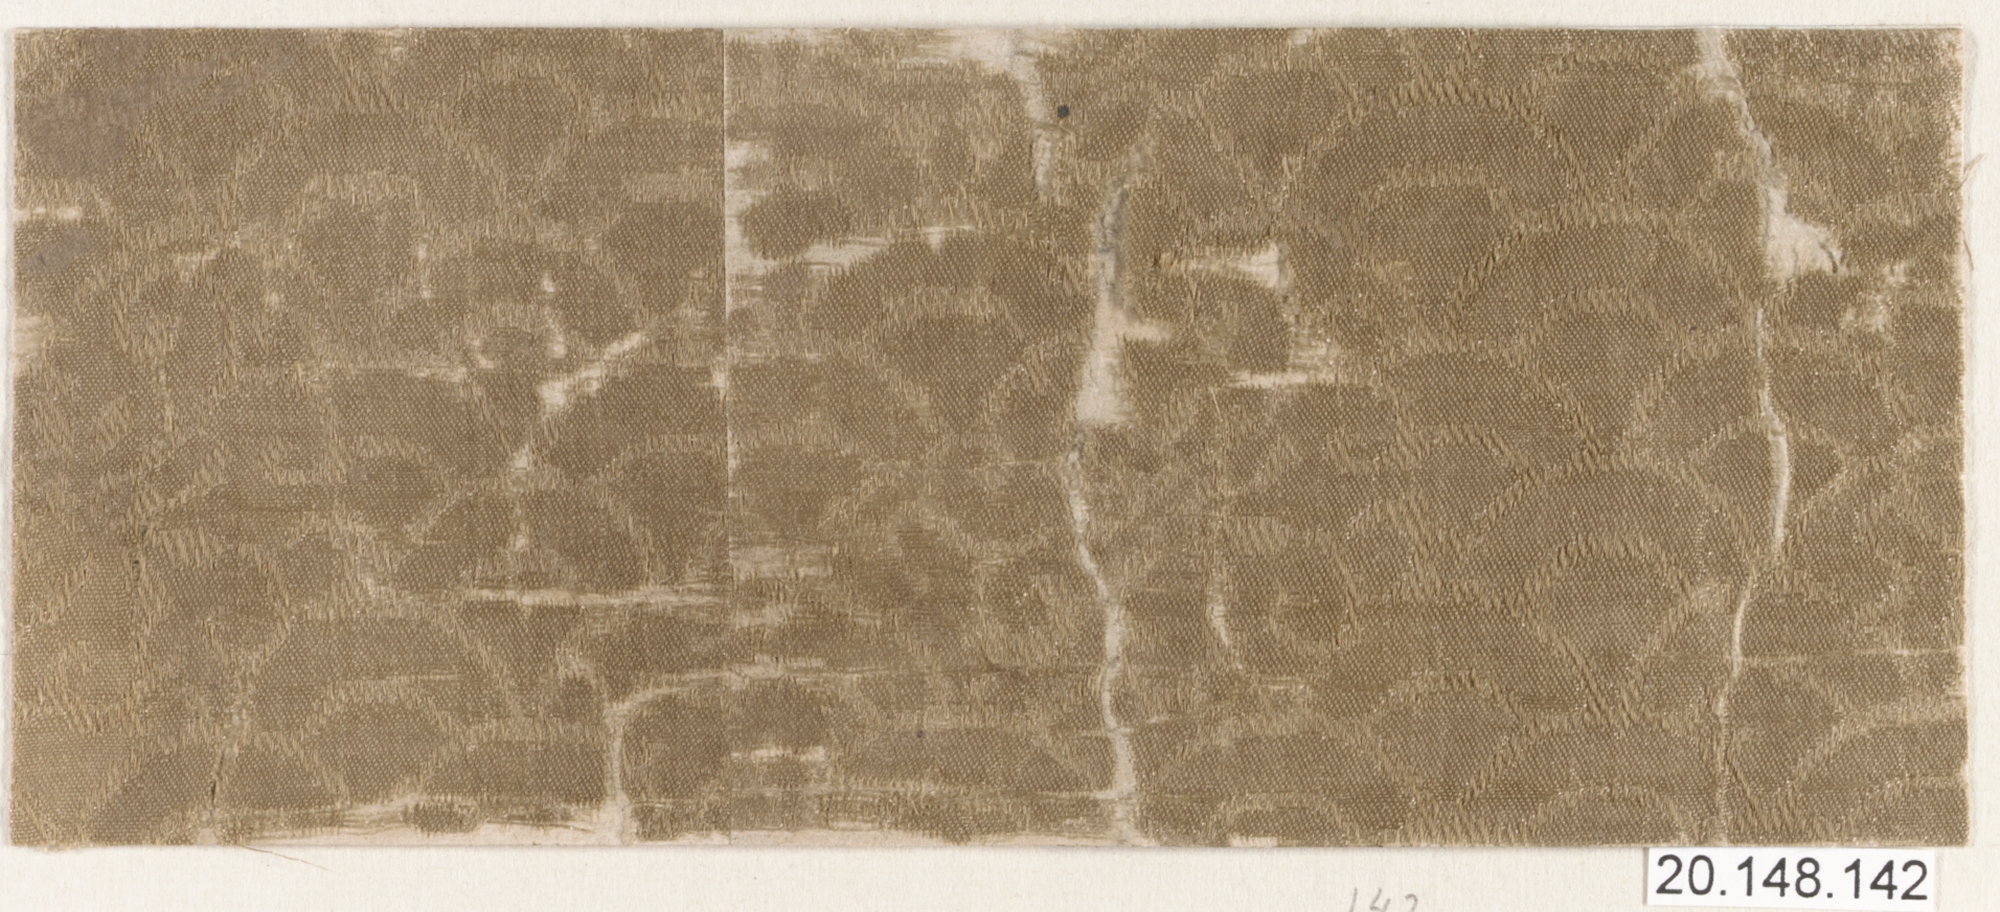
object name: piece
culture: japanese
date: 1601-1700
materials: silk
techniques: compound weave